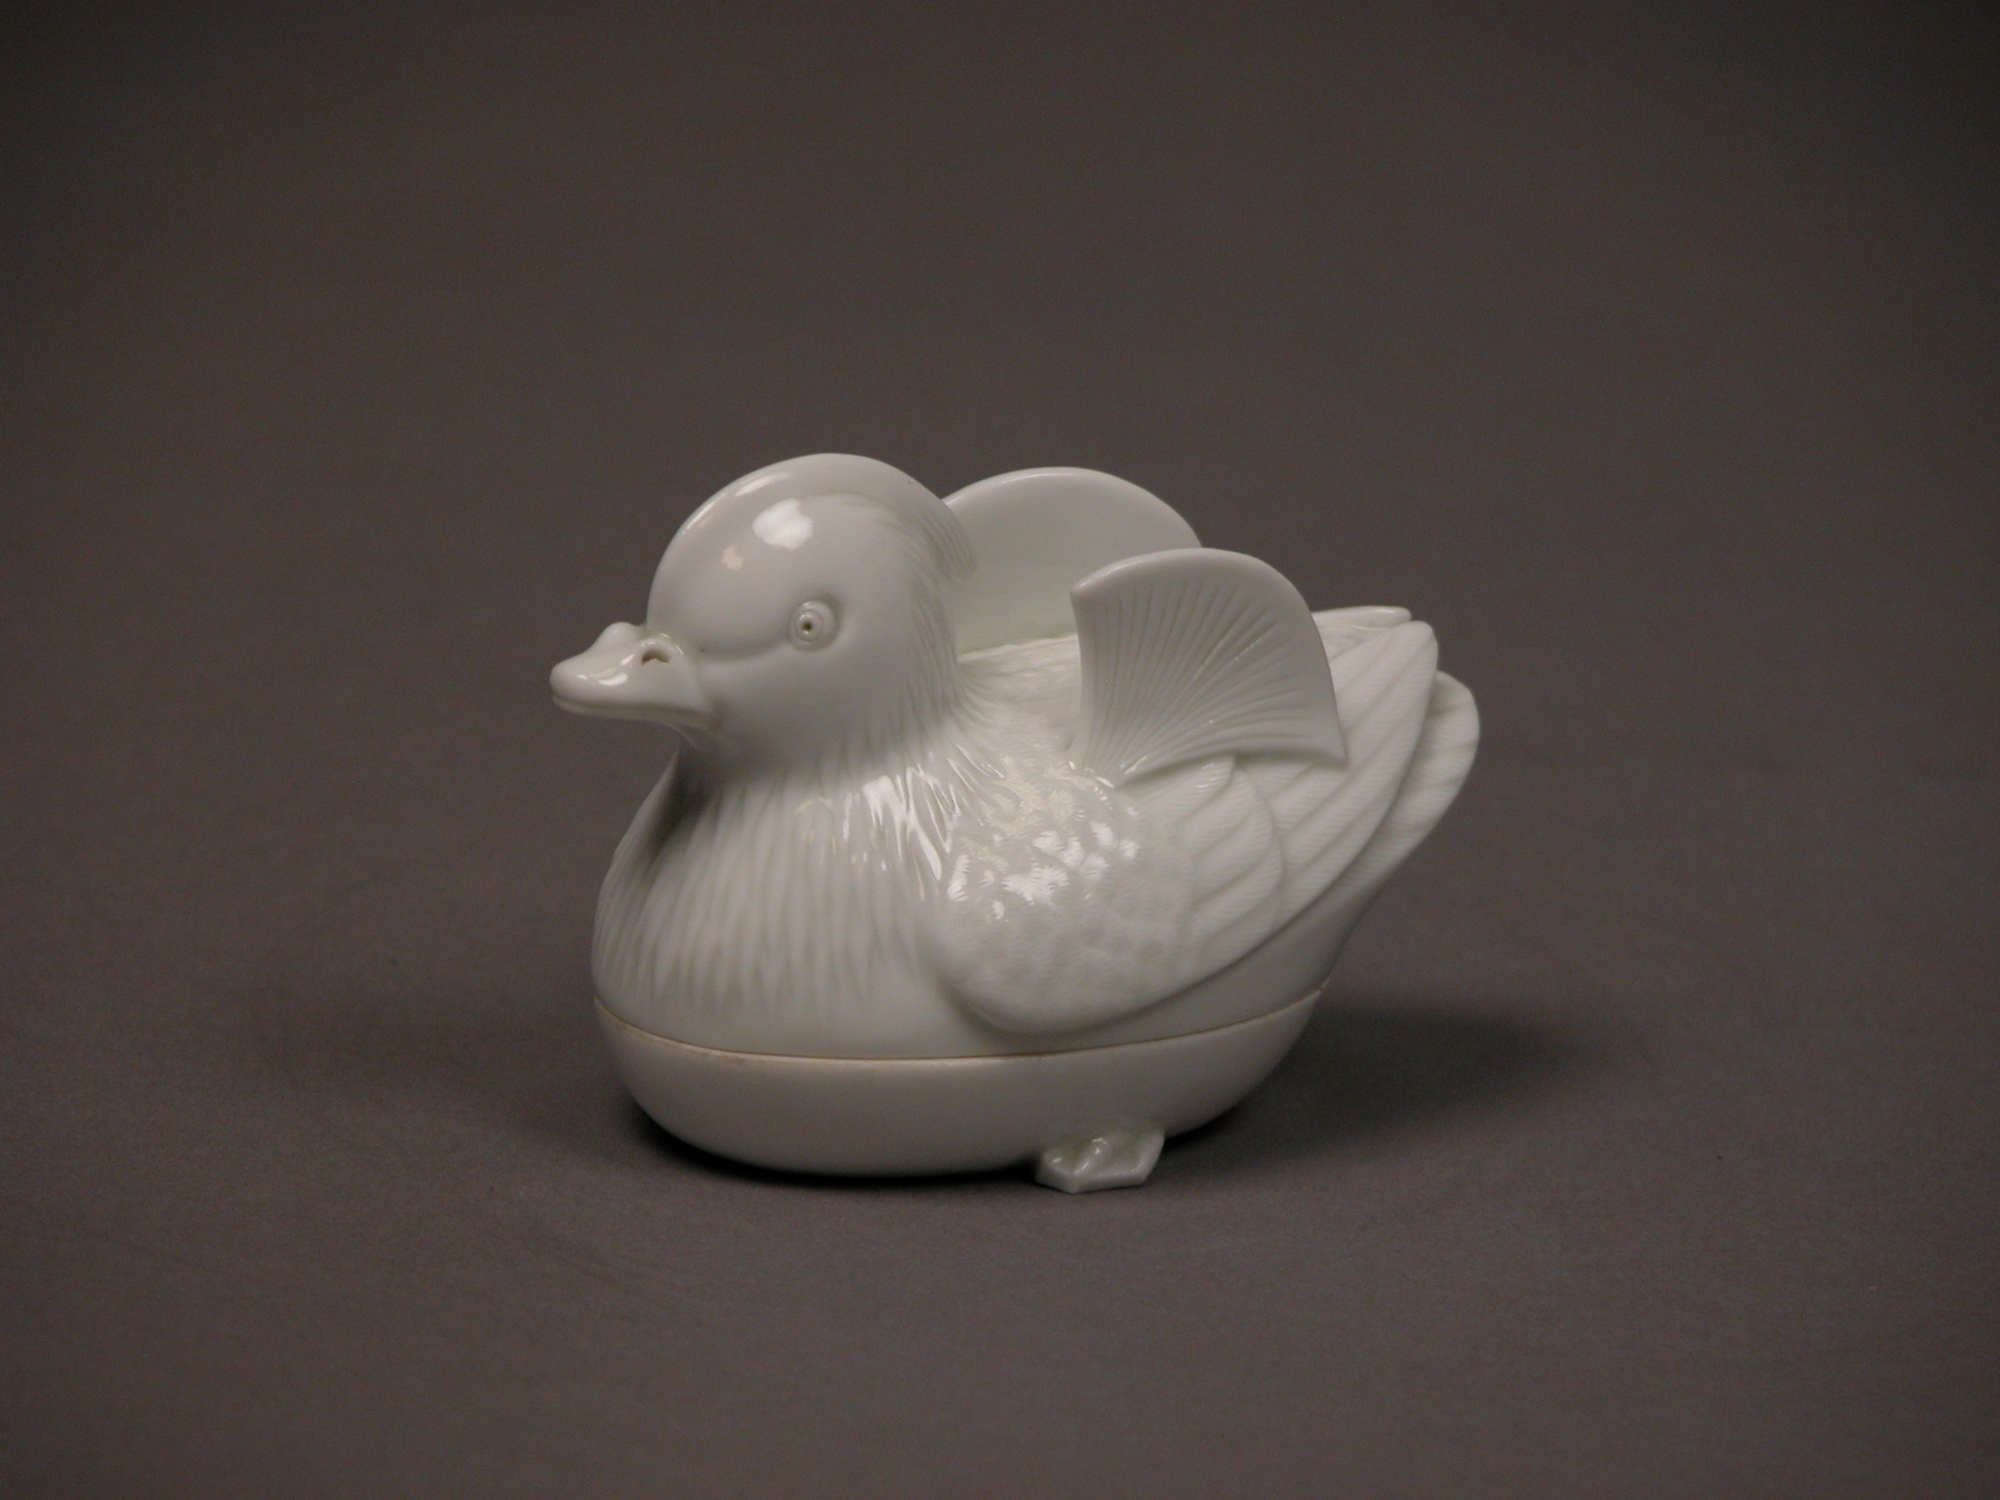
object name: covered incense box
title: Covered incense box In form of mandarin duck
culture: japanese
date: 1800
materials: porcelain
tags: ducks